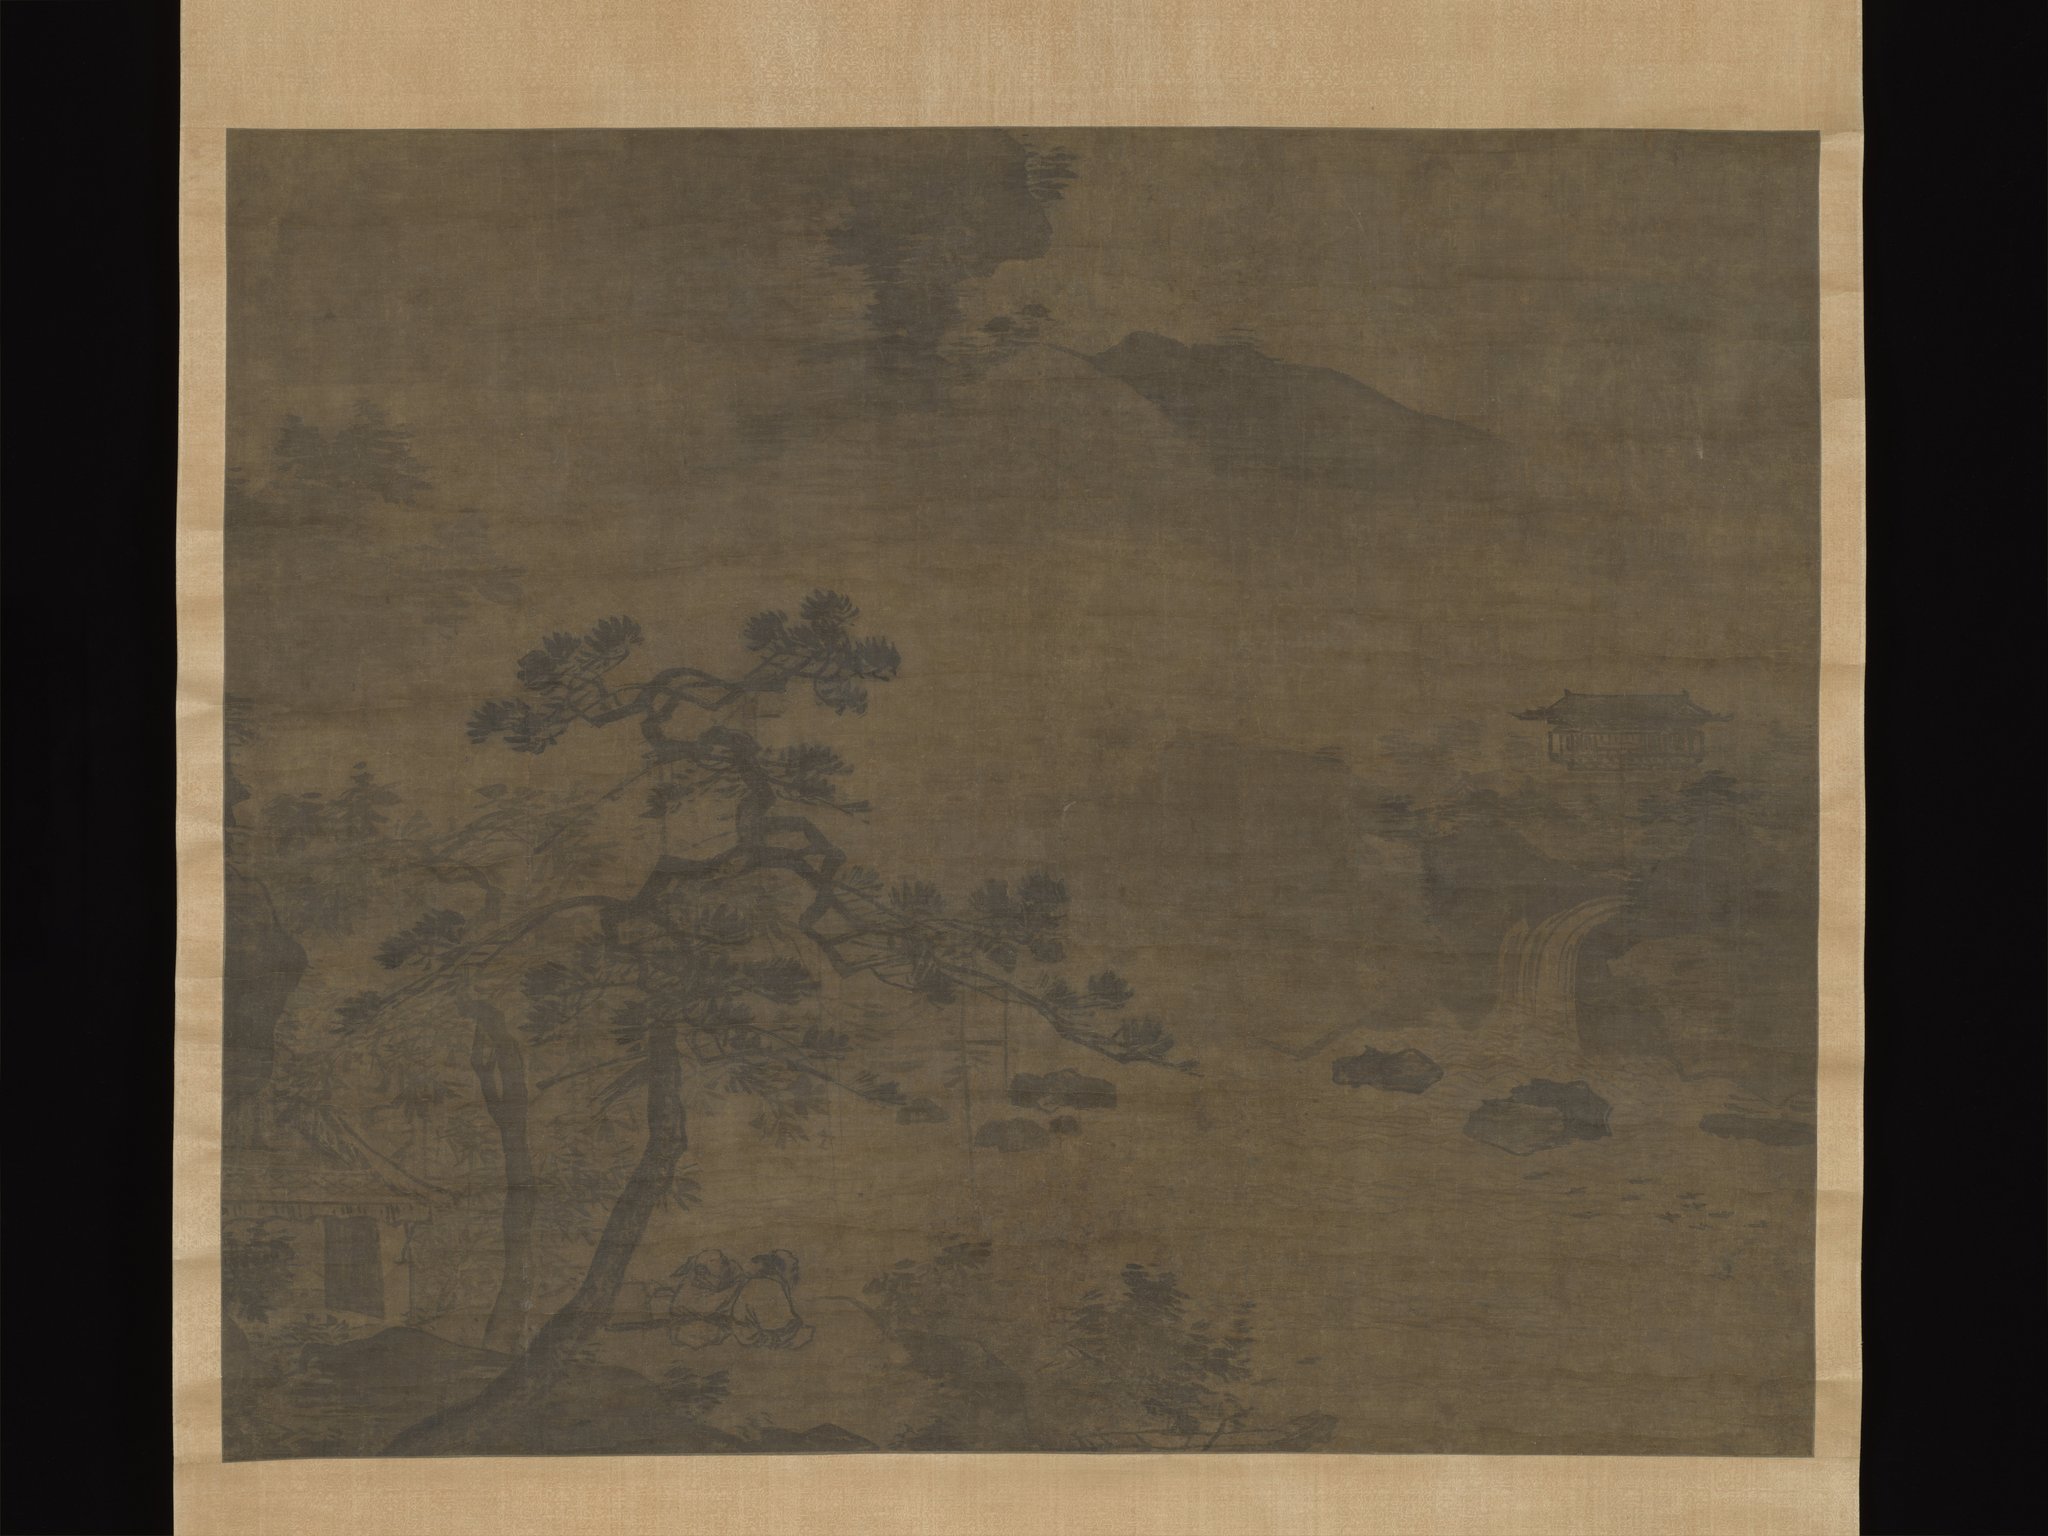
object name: hanging scroll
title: Landscape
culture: chinese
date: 1368-1644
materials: silk